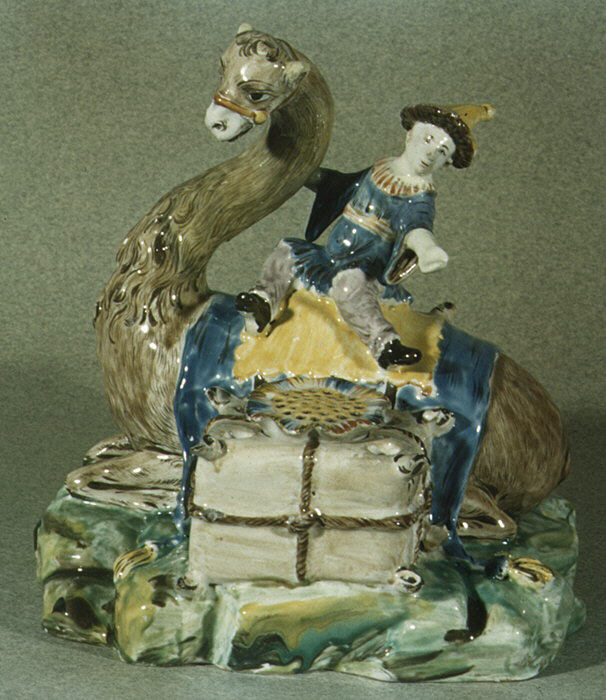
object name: inkstand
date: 1750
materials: faience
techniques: glazing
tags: men,camels